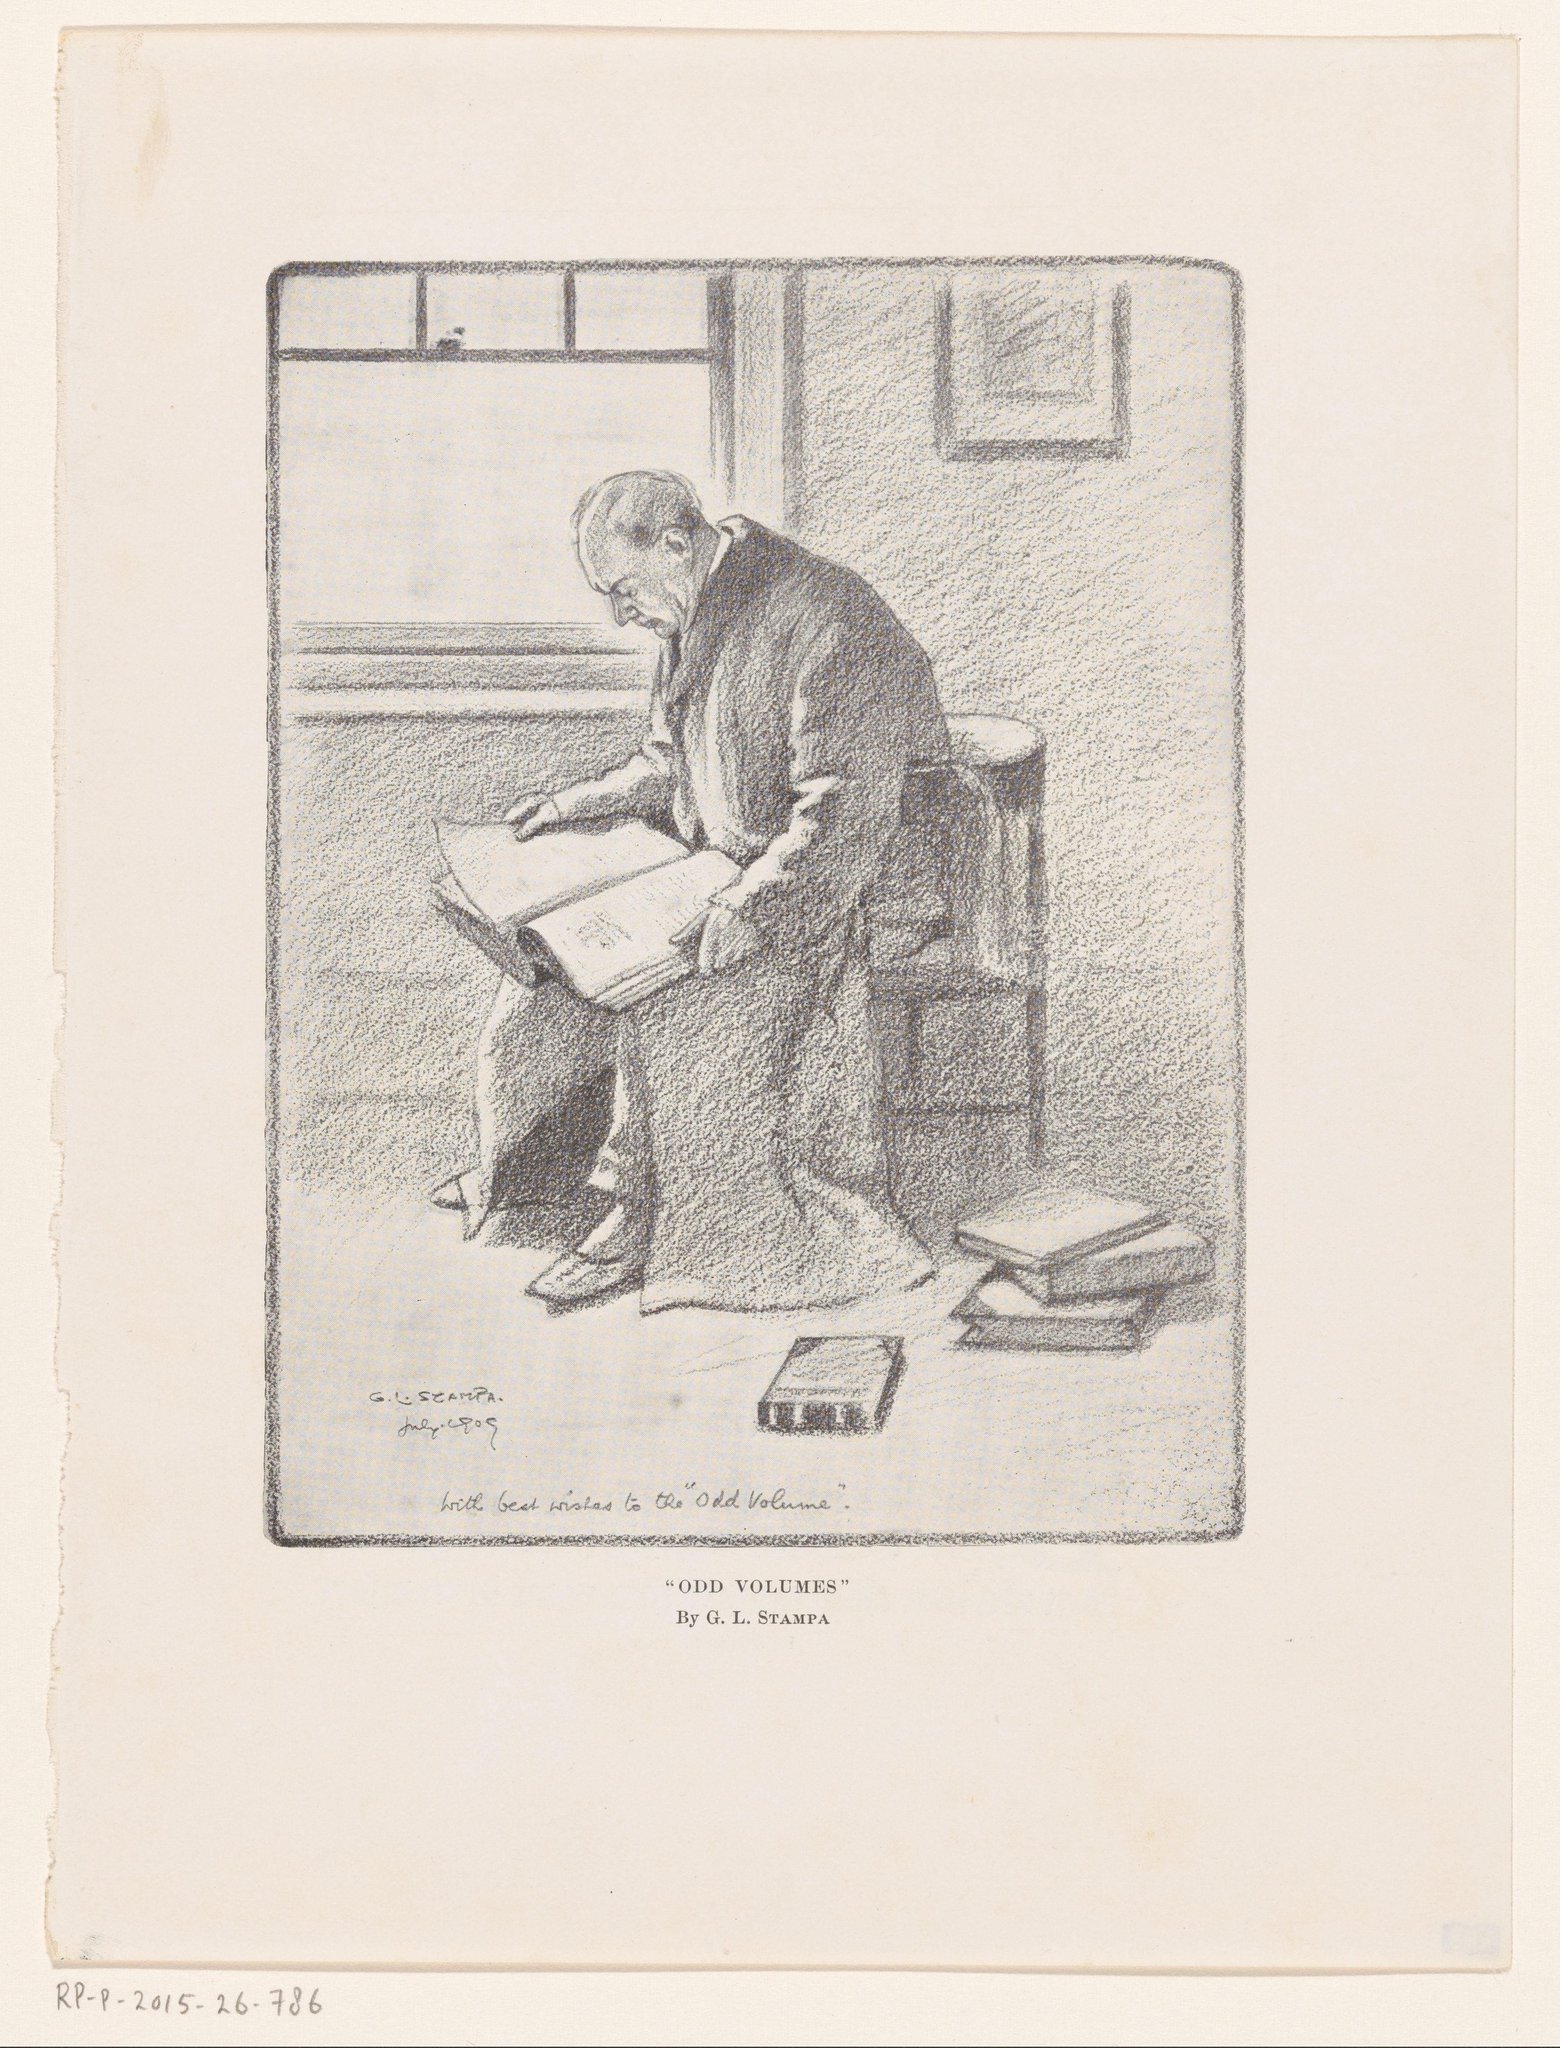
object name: print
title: Zittende man met een boek voor het raam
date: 1907-1909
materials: paper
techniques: autotype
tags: book, newspaper, news-sheet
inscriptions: collector's mark: Lugt 4780, collector's mark: Lugt 2228